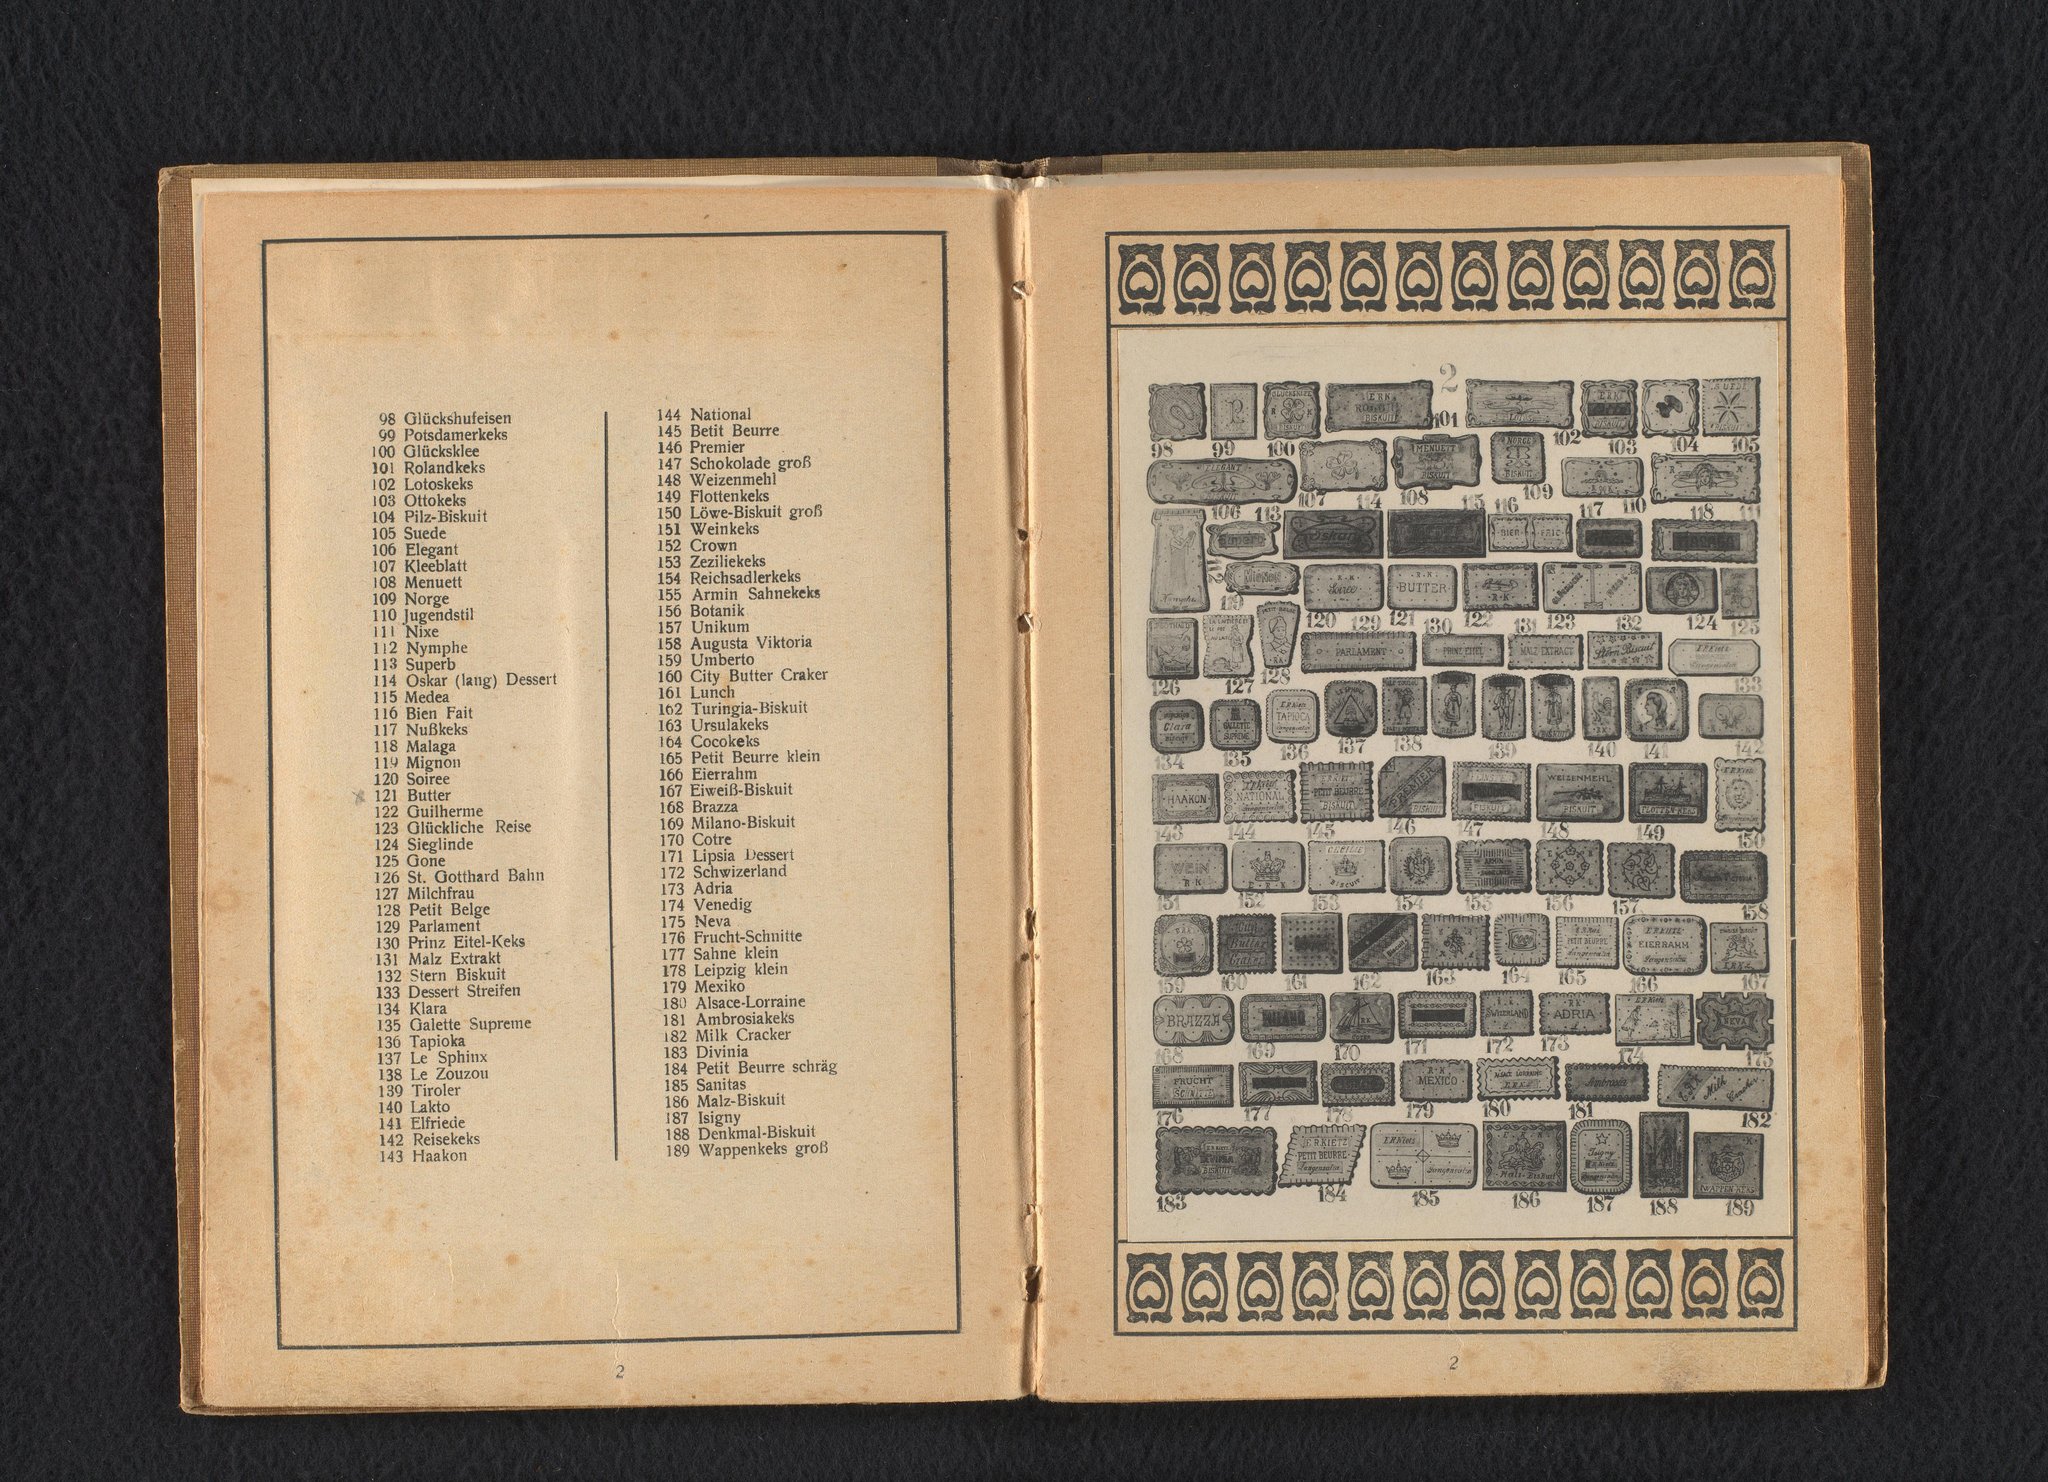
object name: photomechanical print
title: Verschillende Engelse koekjes en biscuits als voorbeeld bij recepten 98-189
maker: Anonymous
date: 1900-1905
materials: paper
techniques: photograph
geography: bad langensalza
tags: pastry cook, moulds for biscuits, biscuits